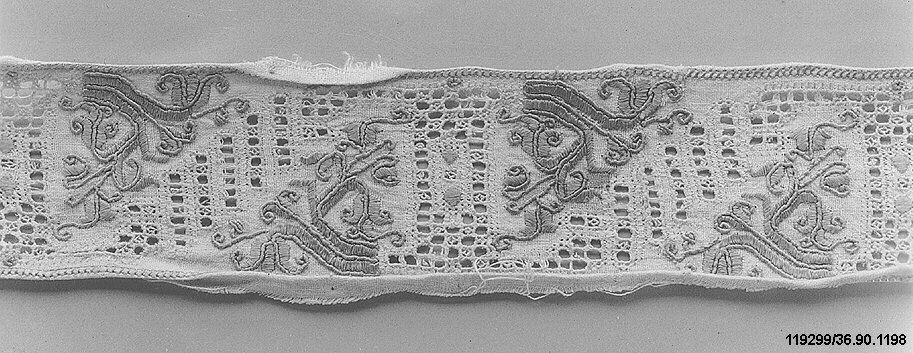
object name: band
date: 1501-1600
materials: linen, silk